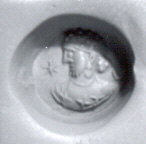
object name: stamp seal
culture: sasanian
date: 201-700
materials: stone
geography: iran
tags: men,profiles